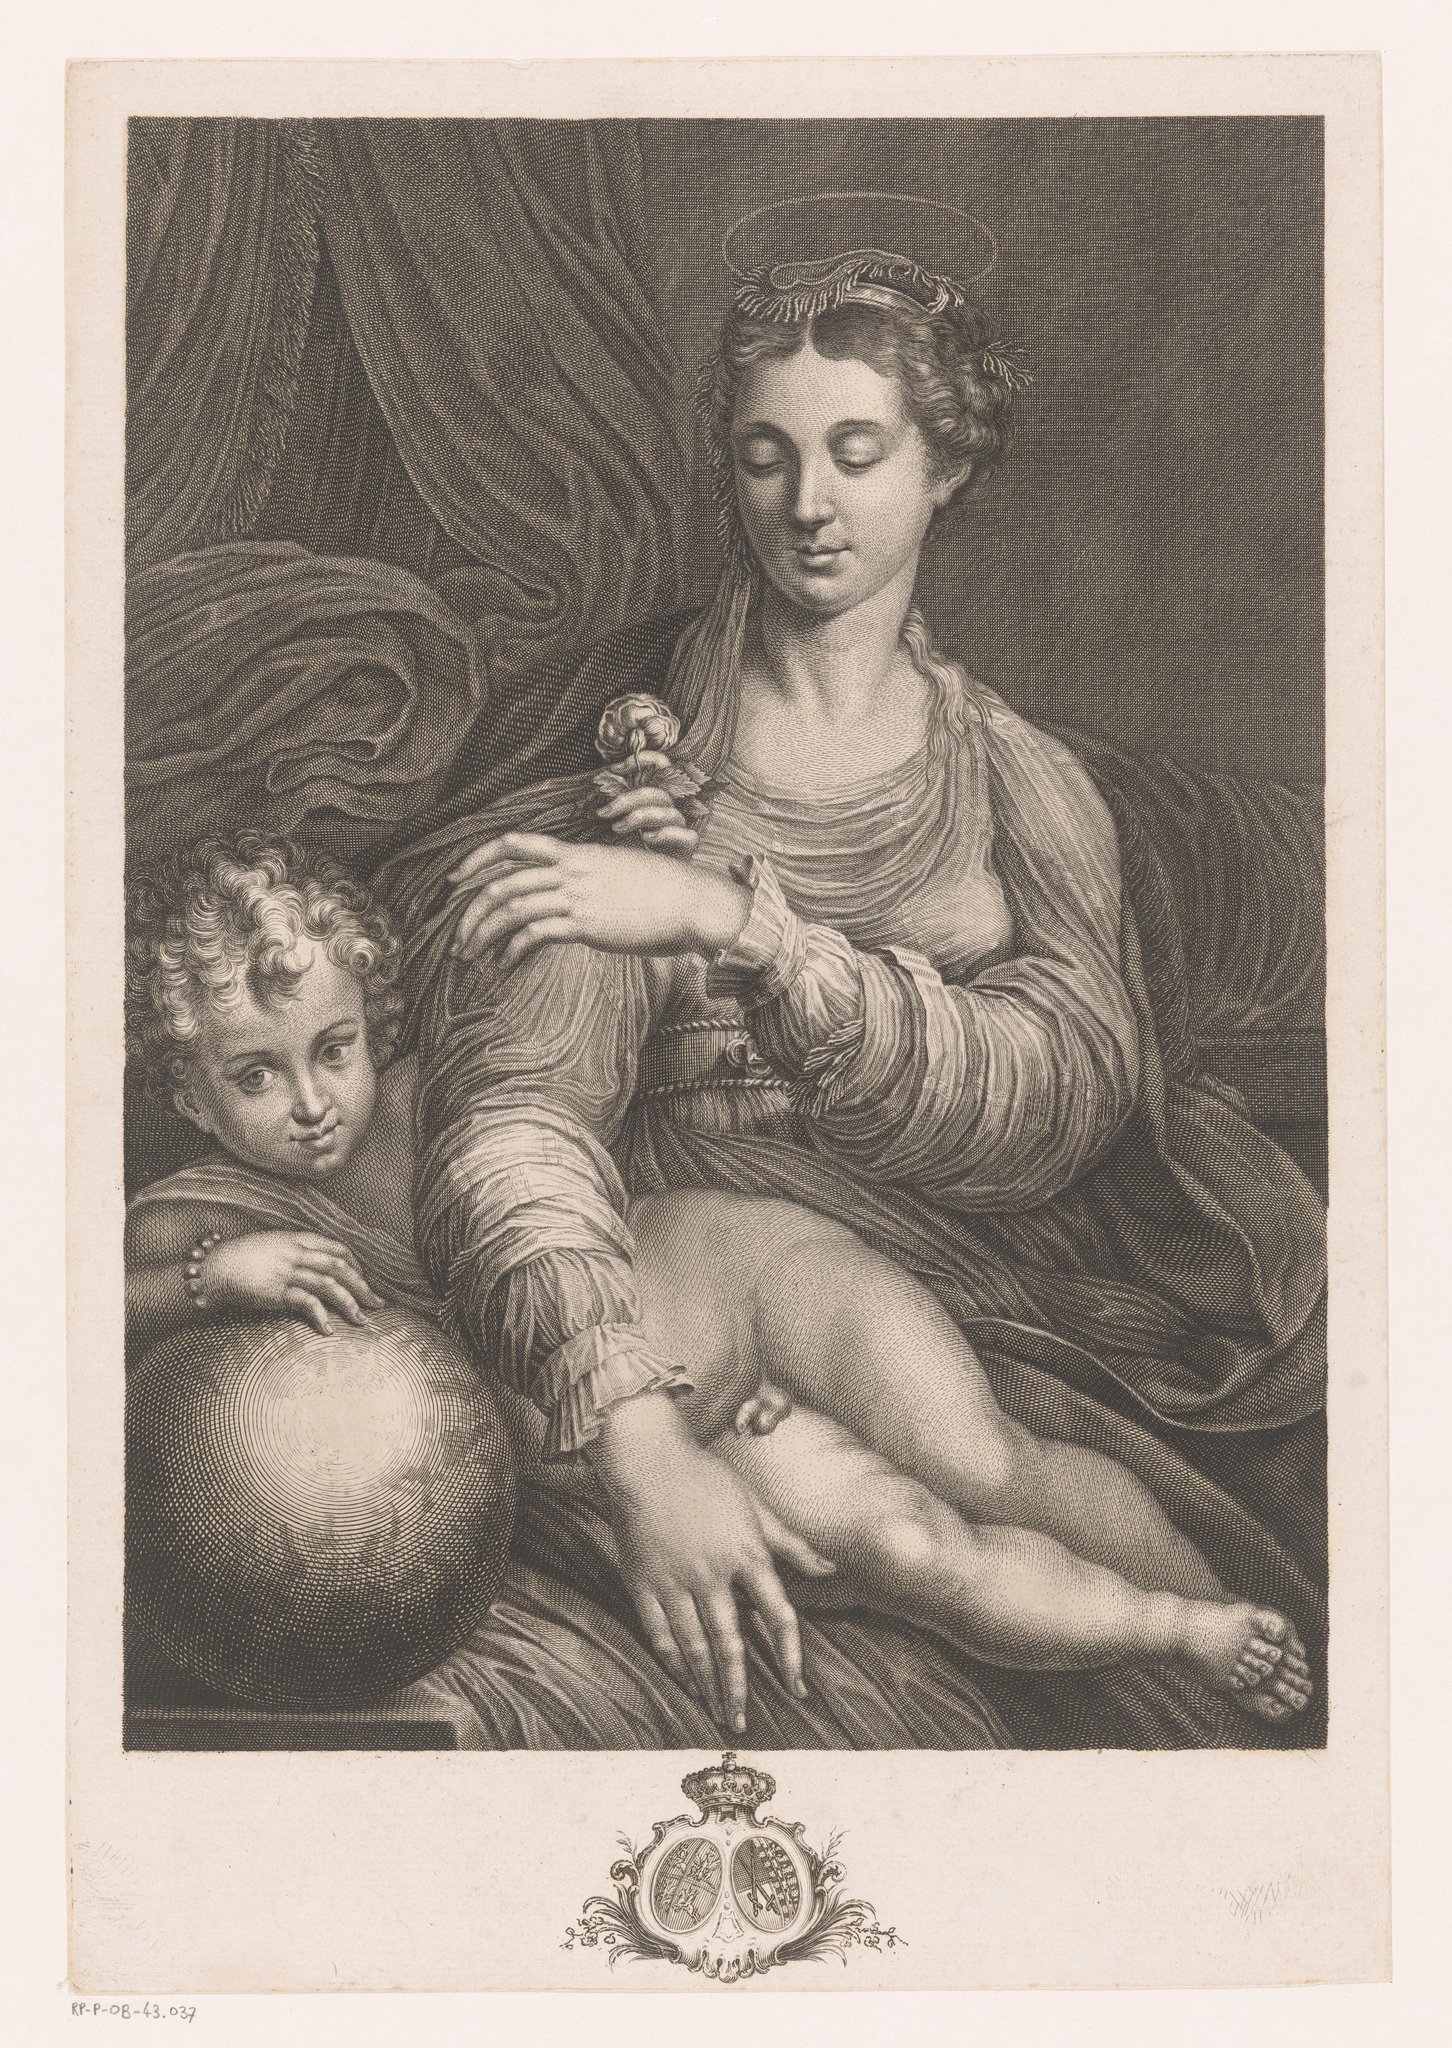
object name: print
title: Maria en Kind met roos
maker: johann christoph teucher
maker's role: print maker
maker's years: 1715-1763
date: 1725-1763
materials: paper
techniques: engraving, etching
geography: italy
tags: mary sitting or enthroned, the christ-child in front of her, lying in her lap (or in front of her bosom), sometimes in pietà-posture, armorial bearing, heraldry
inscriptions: collector's mark: Lugt 240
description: Het schilderij door Parmigianino, beter bekend als de 'Madonna della Rosa' bevindt zich in de Gemäldegalerie Alte Meister te Dresden.